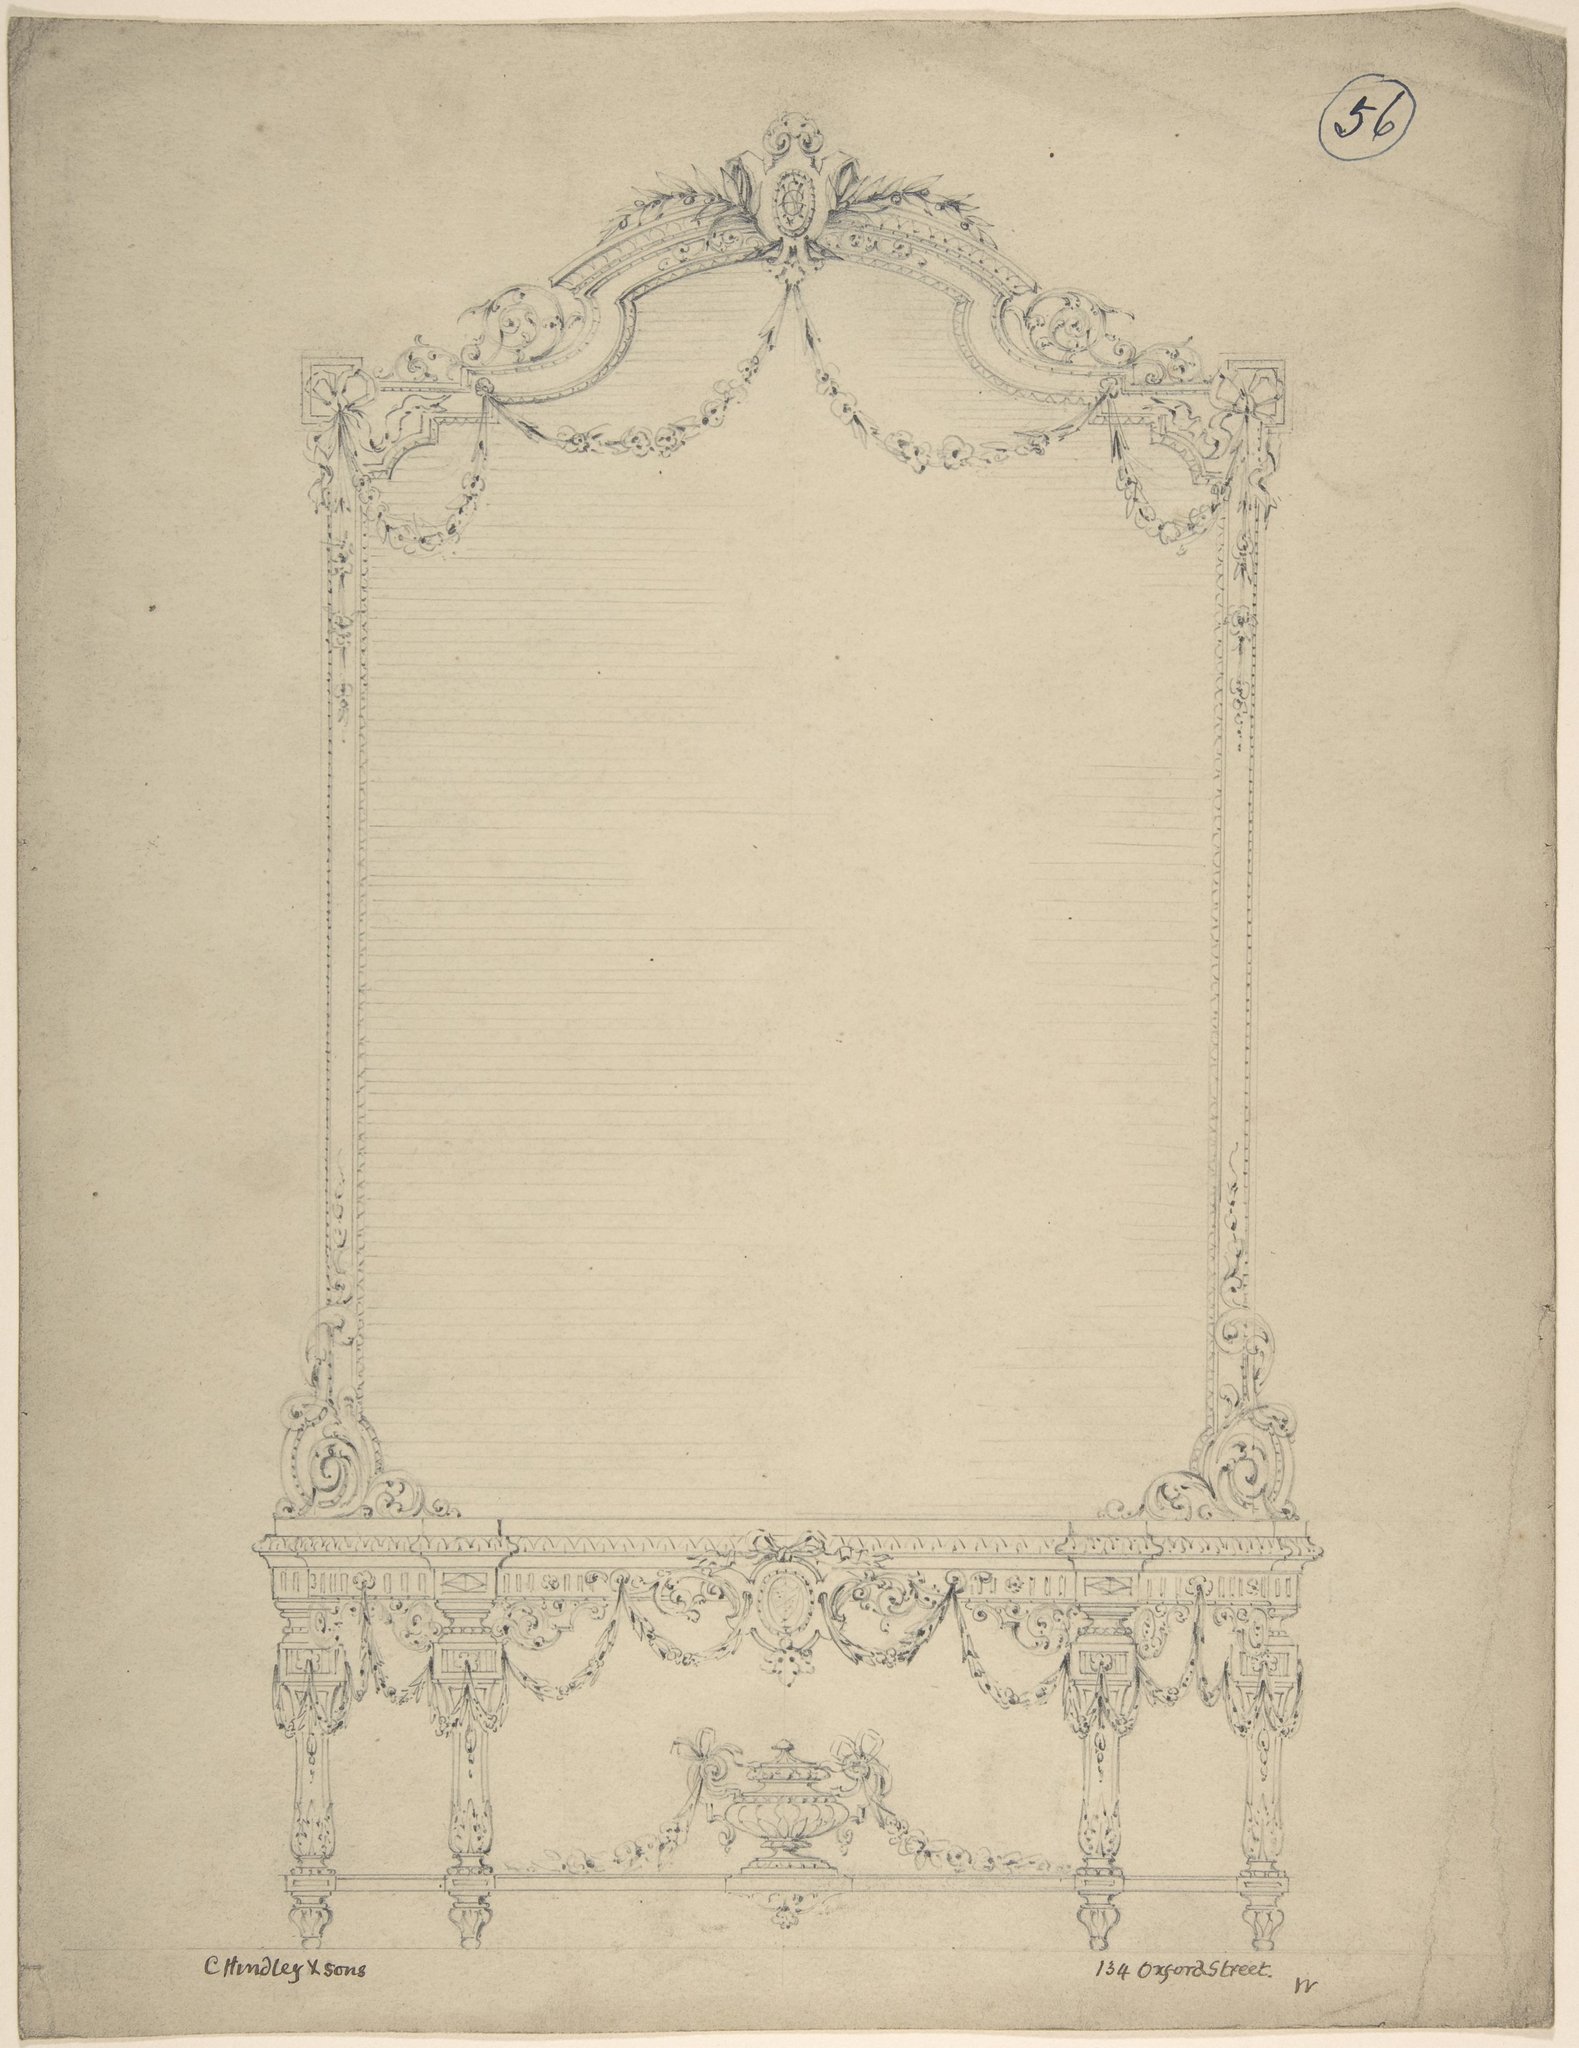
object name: drawing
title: Design for a Rectangular Mirror over a Side Table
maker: charles hindley and sons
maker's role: artist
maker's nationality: british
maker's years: 1841-1917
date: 1841-1884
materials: graphite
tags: ornament,tables,mirrors